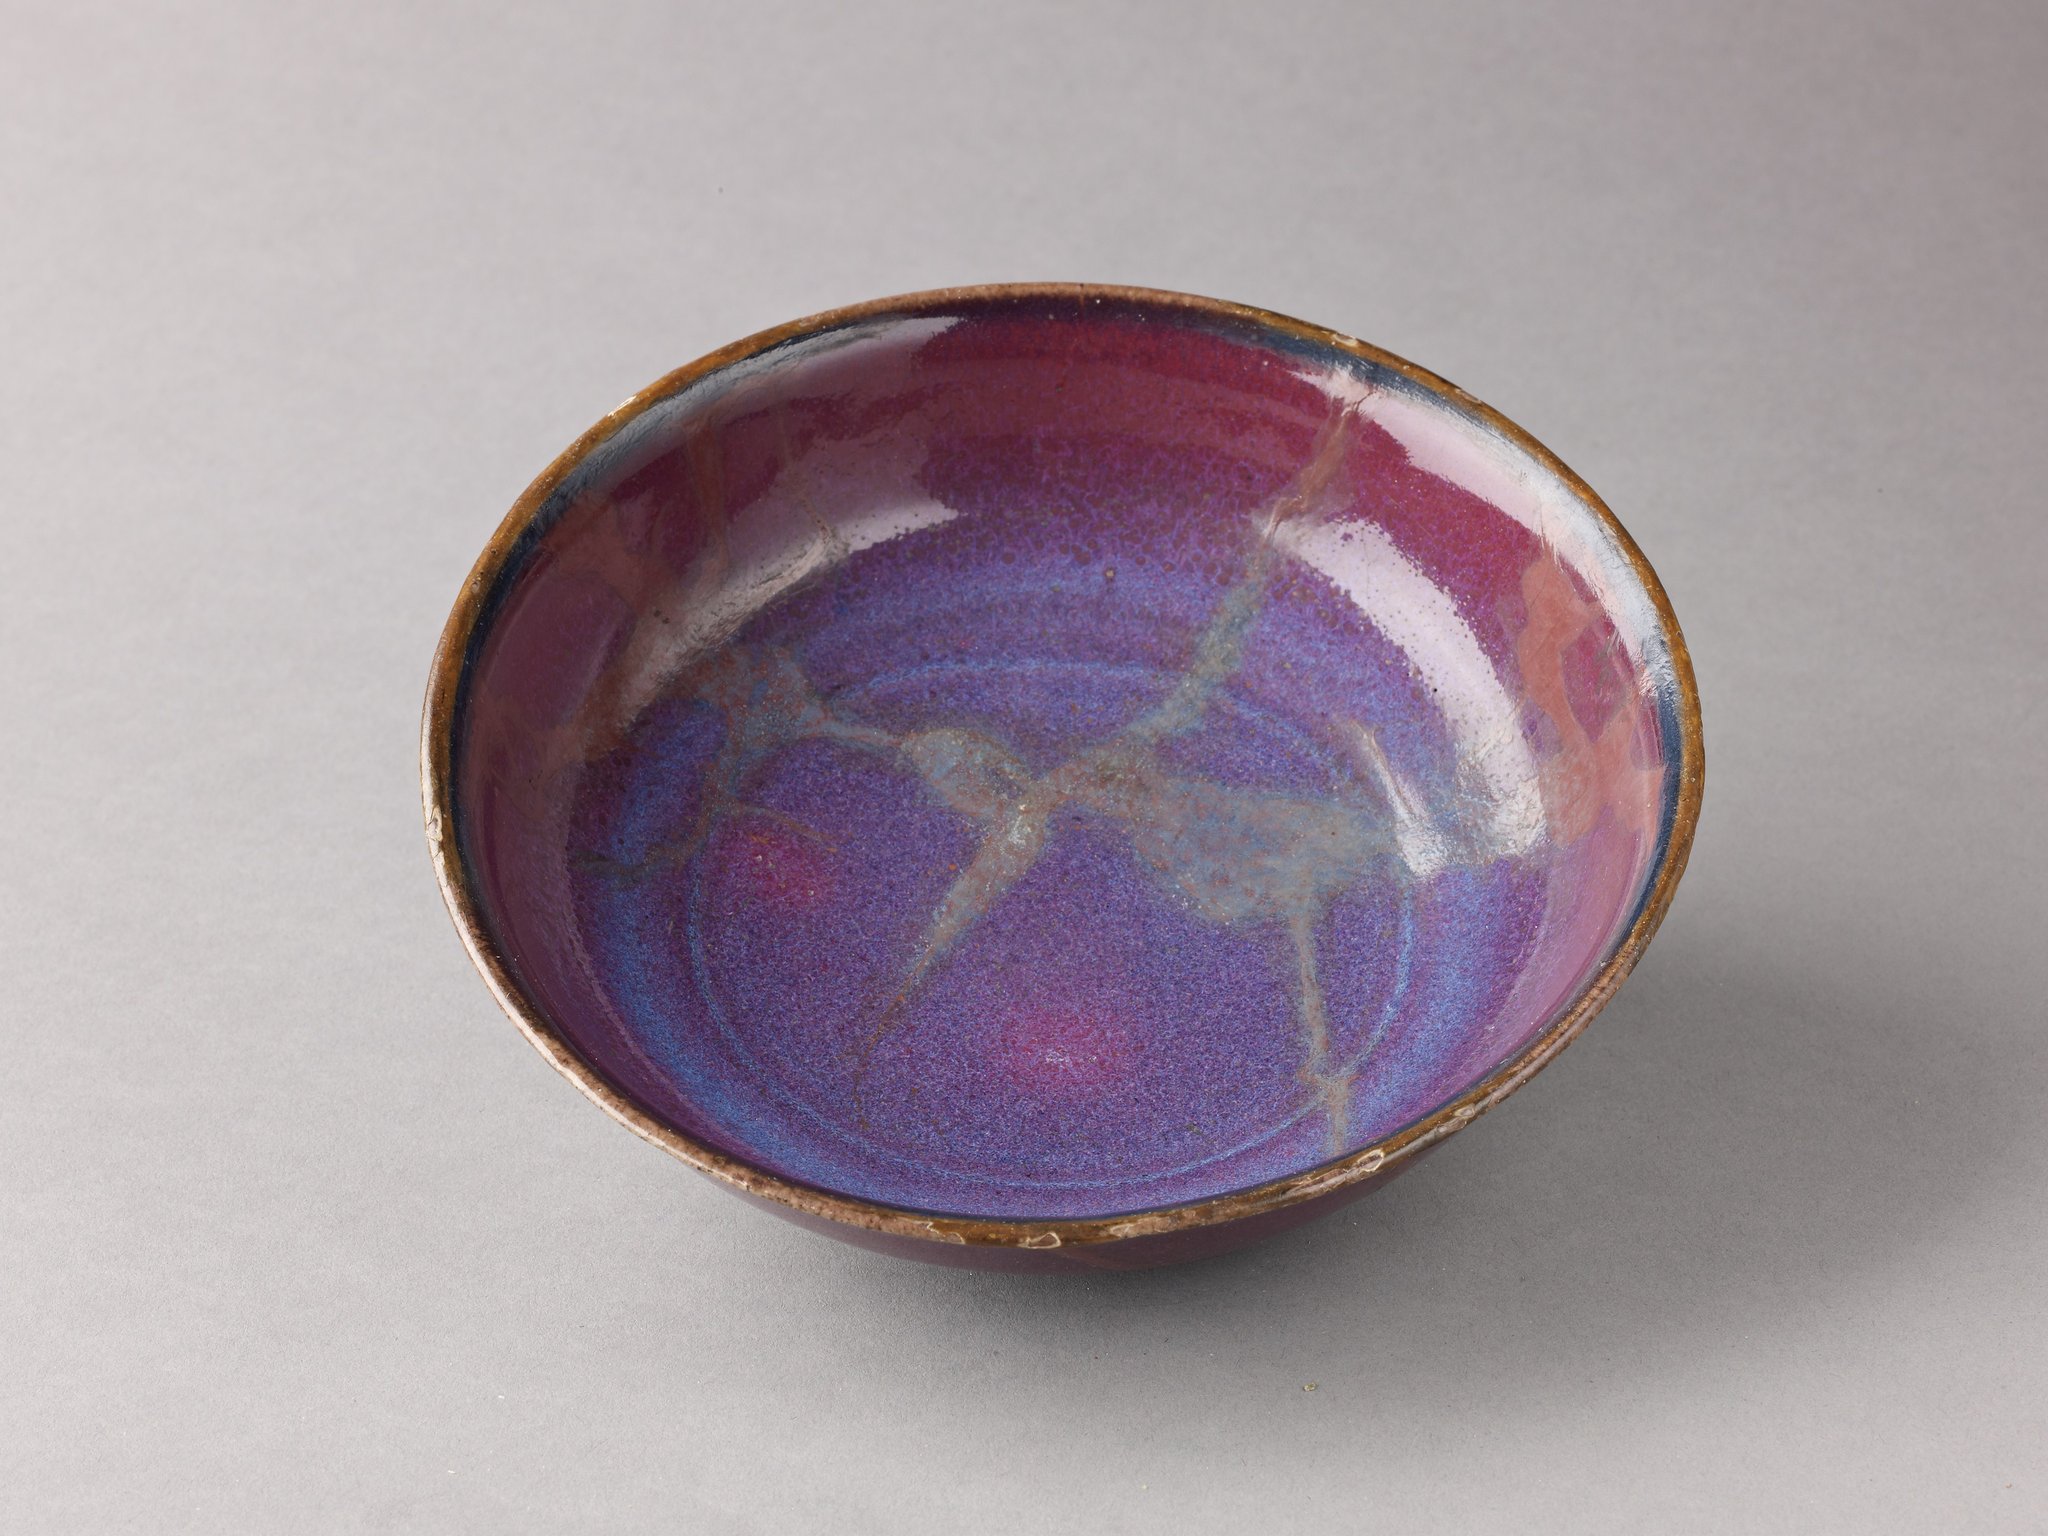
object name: dish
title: Shallow dish, Jun-type ware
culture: chinese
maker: chinese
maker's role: artist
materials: glaze, stoneware